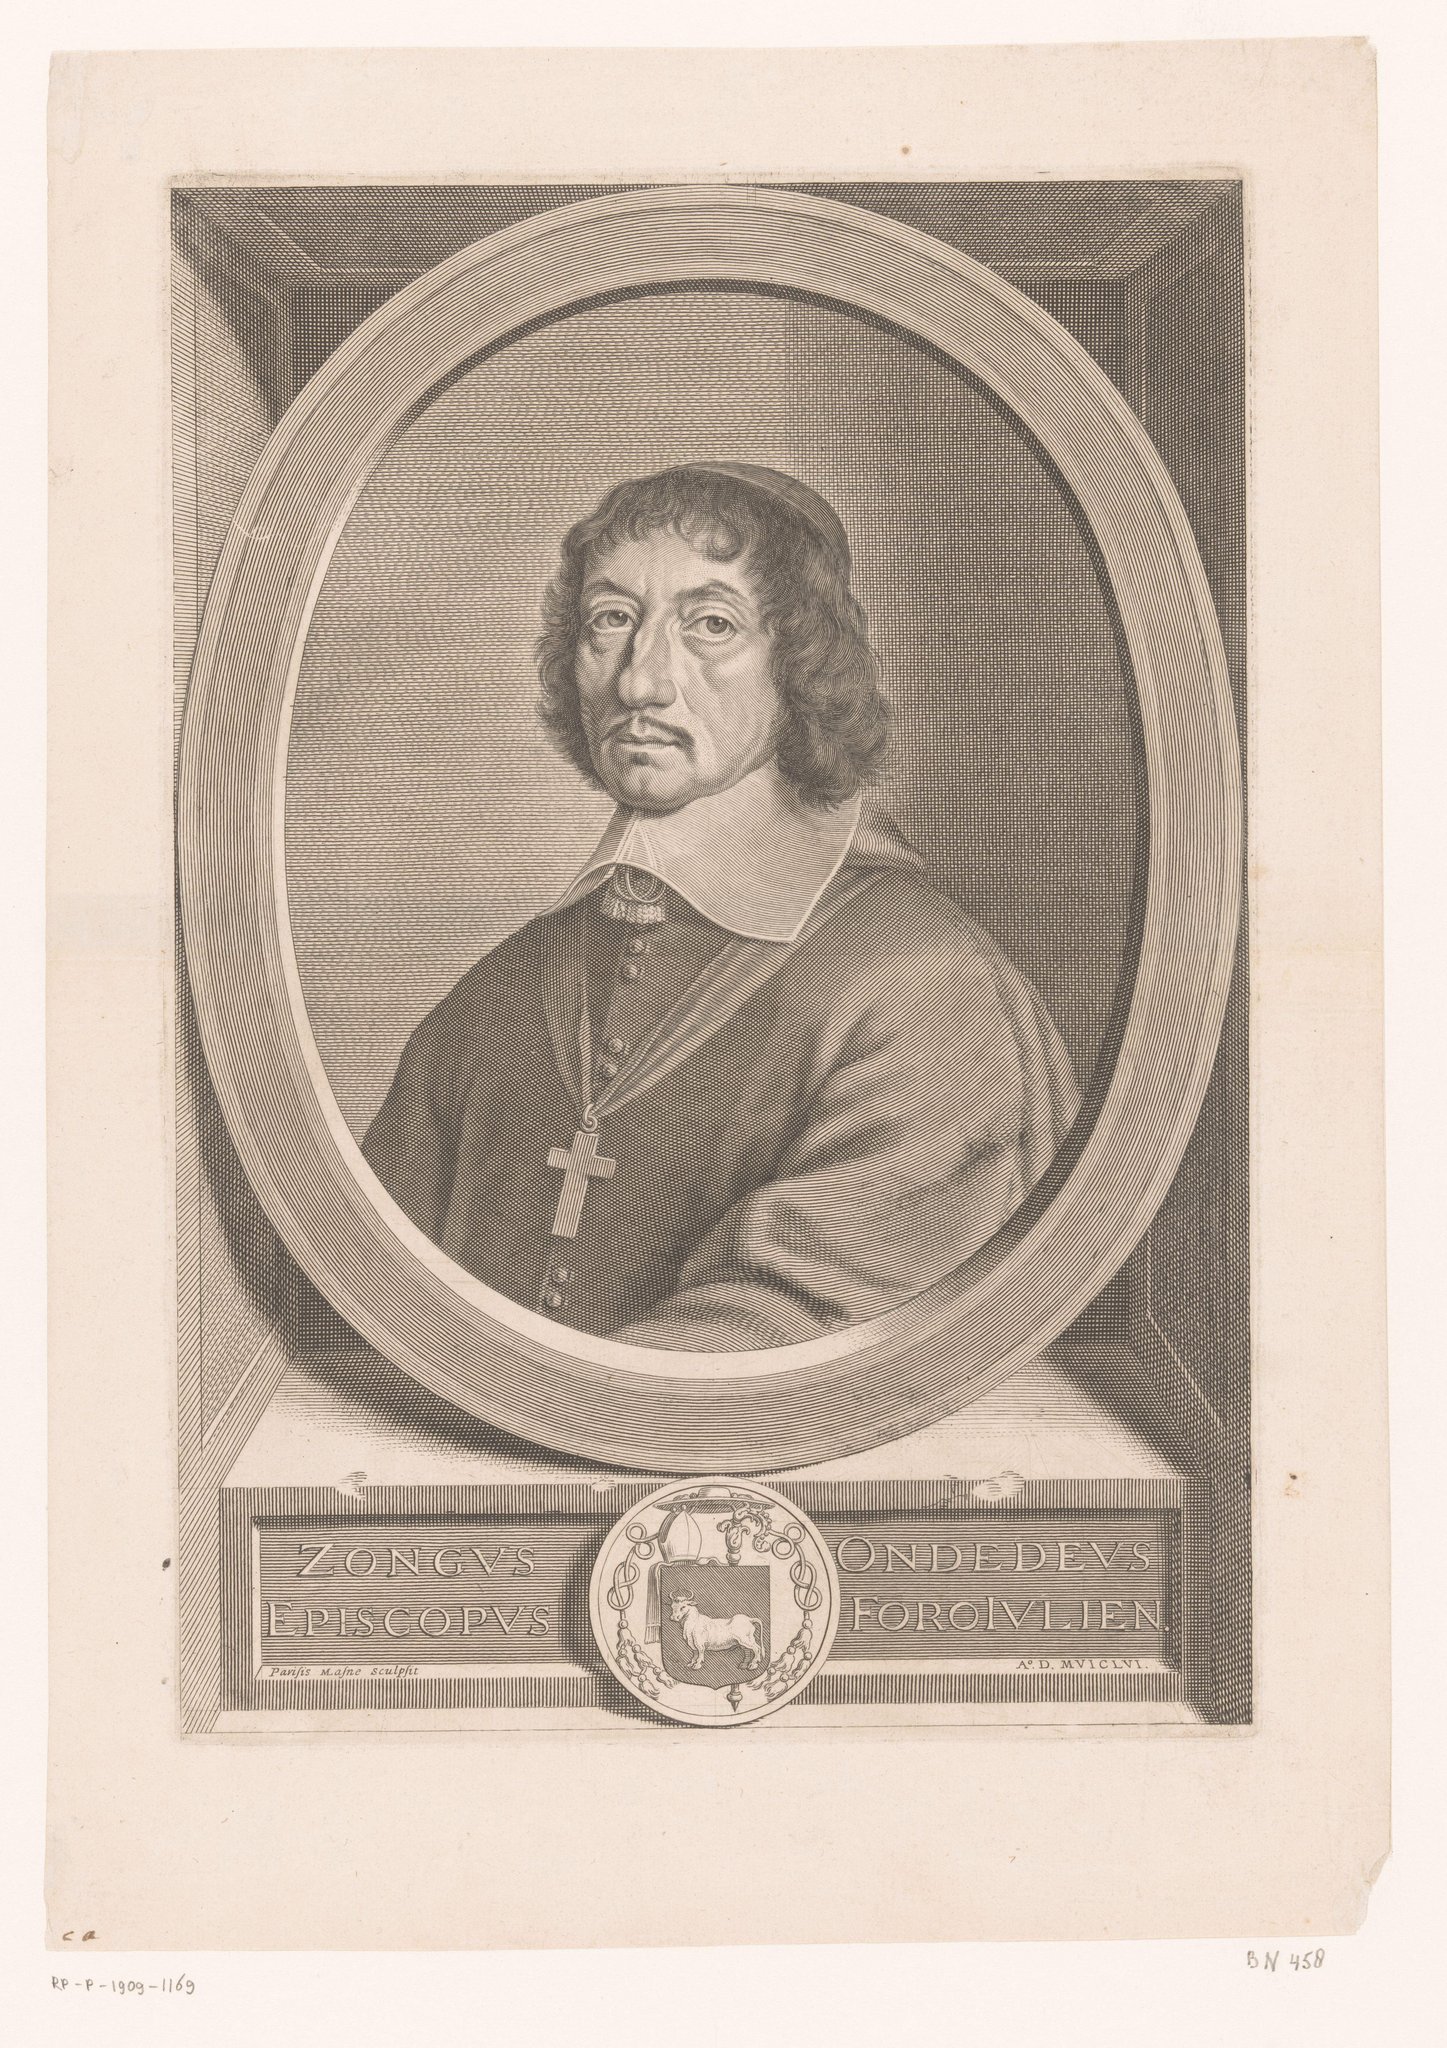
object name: print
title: Portret van Joseph Zongo Ondedei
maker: michel lasne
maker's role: print maker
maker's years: 1590-1667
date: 1656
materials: paper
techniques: engraving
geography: paris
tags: archbishop, bishop, etc. (roman catholic), historical persons, armorial bearing, heraldry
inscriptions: collector's mark: Lugt 2228